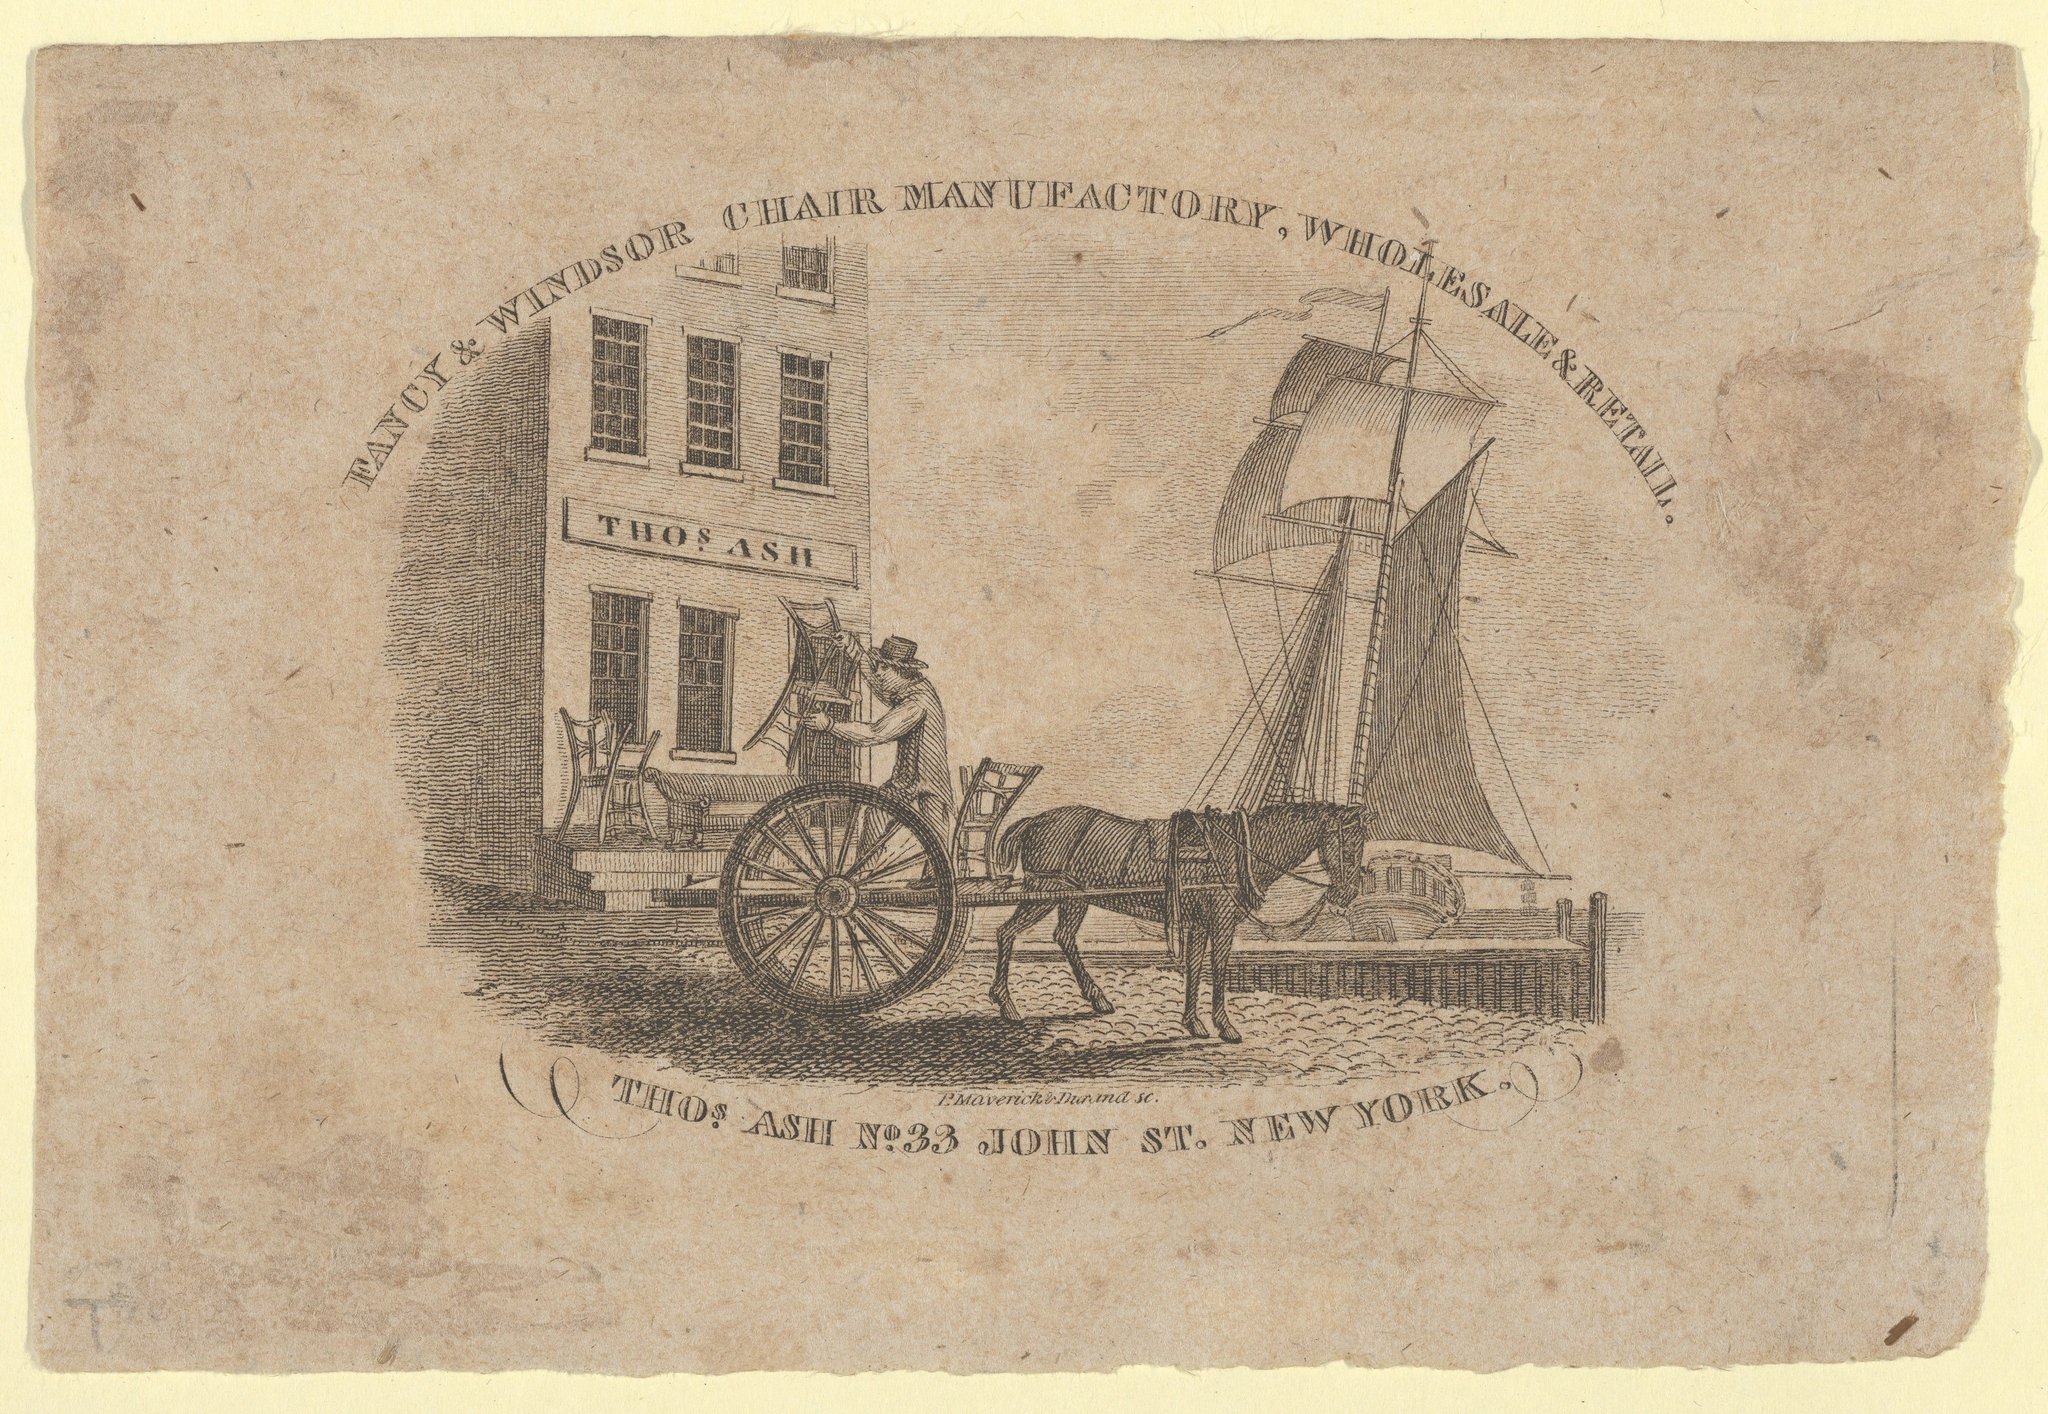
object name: print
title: Fancy & Windsor Chair Manufactory, Wholesale & Retail, Thomas Ash, No. 33 John Street, New York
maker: asher brown durand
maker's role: artist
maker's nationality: american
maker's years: 1796-1886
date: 1817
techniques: engraving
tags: men,women,carts,ships